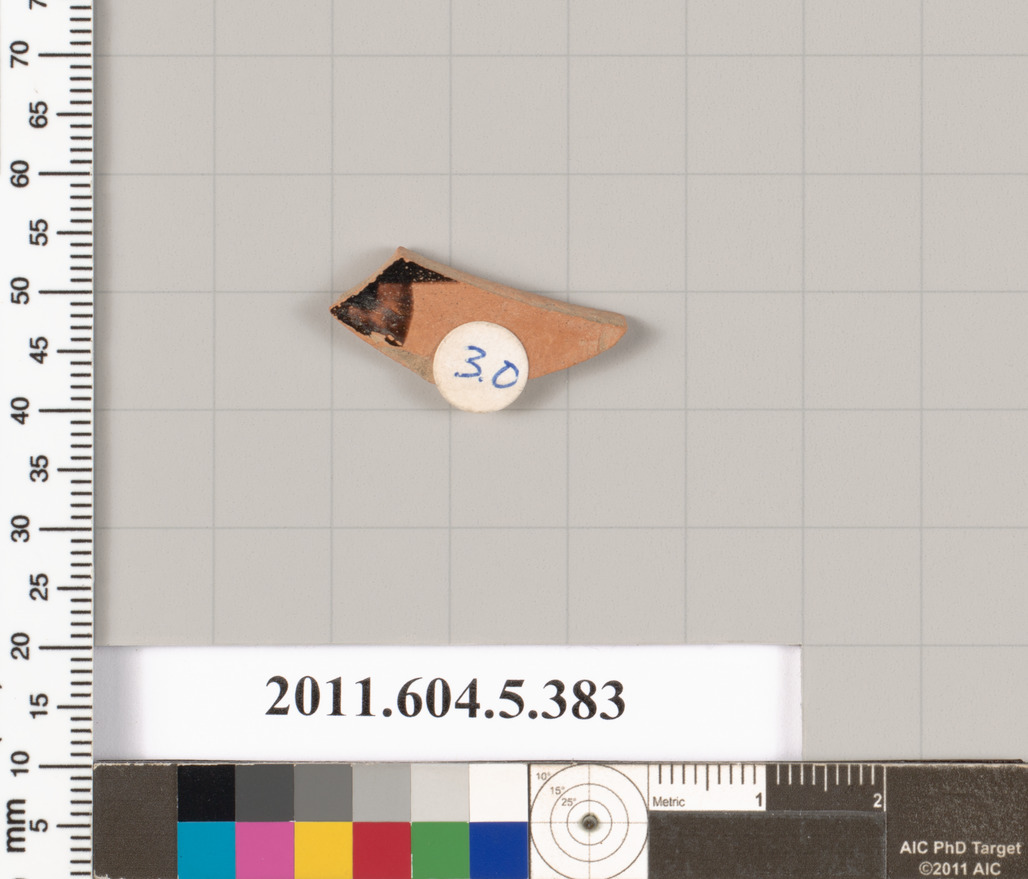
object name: kylix fragment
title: Terracotta fragment of a kylix (drinking cup)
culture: greek, attic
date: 600-401 BCE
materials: terracotta